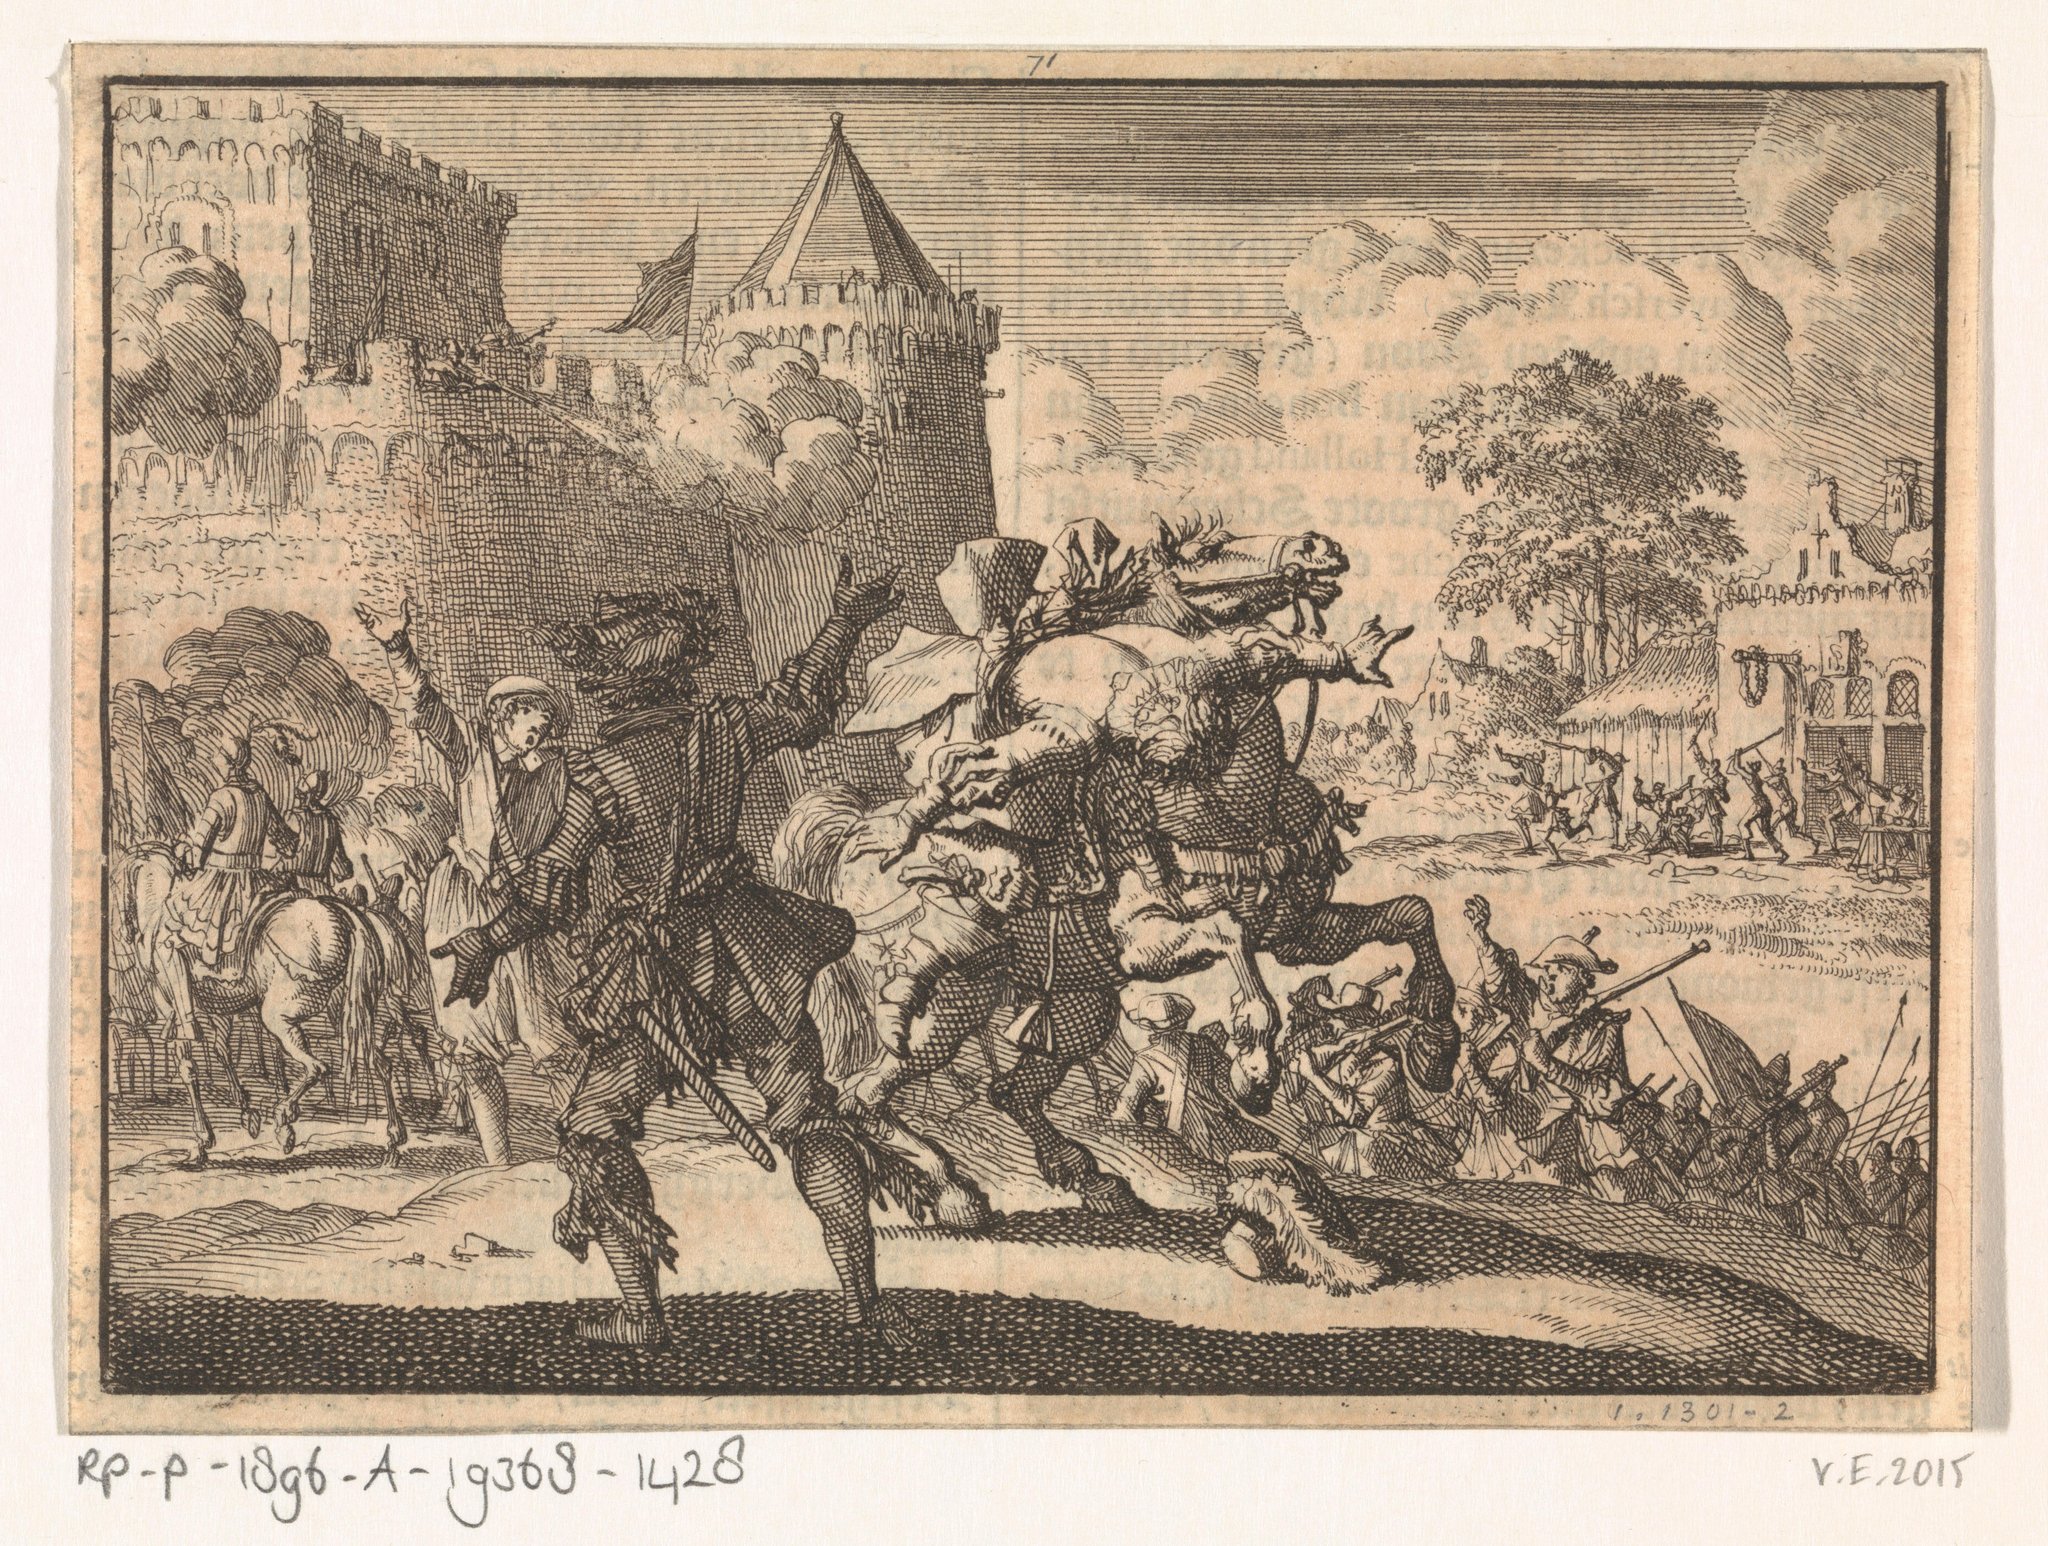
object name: print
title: Keizerlijk bevelhebber Dampier valt van zijn paard na een schot vanaf de muren van Presburg (Bratislava), 1620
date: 1698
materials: paper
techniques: etching, letterpress printing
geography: leiden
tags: horse throwing rider, firearms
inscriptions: collector's mark: Lugt 2228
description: Illustratie uit: Gottfried, Johann Ludwig. Historische kronyck; vervattende een (...) beschrijvingh der aldergedenckwaerdigste geschiedenissen des weerelds, van den aenvangh der scheppingh tot (...) 1576 (2 delen). Leiden: Pieter van der Aa, 1698, dl. I, p. 1301.